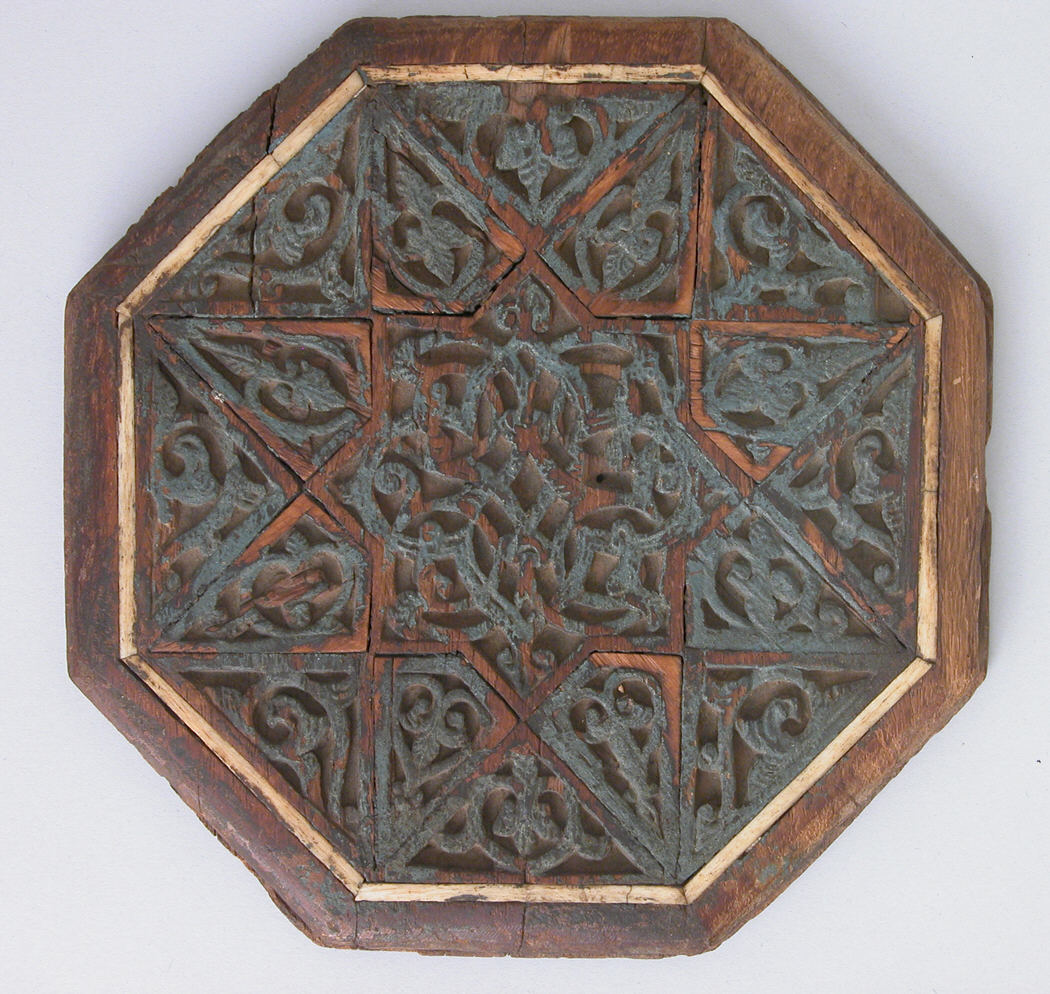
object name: panel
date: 1201-1400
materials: ivory, wood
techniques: carving, inlay, painting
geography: egypt